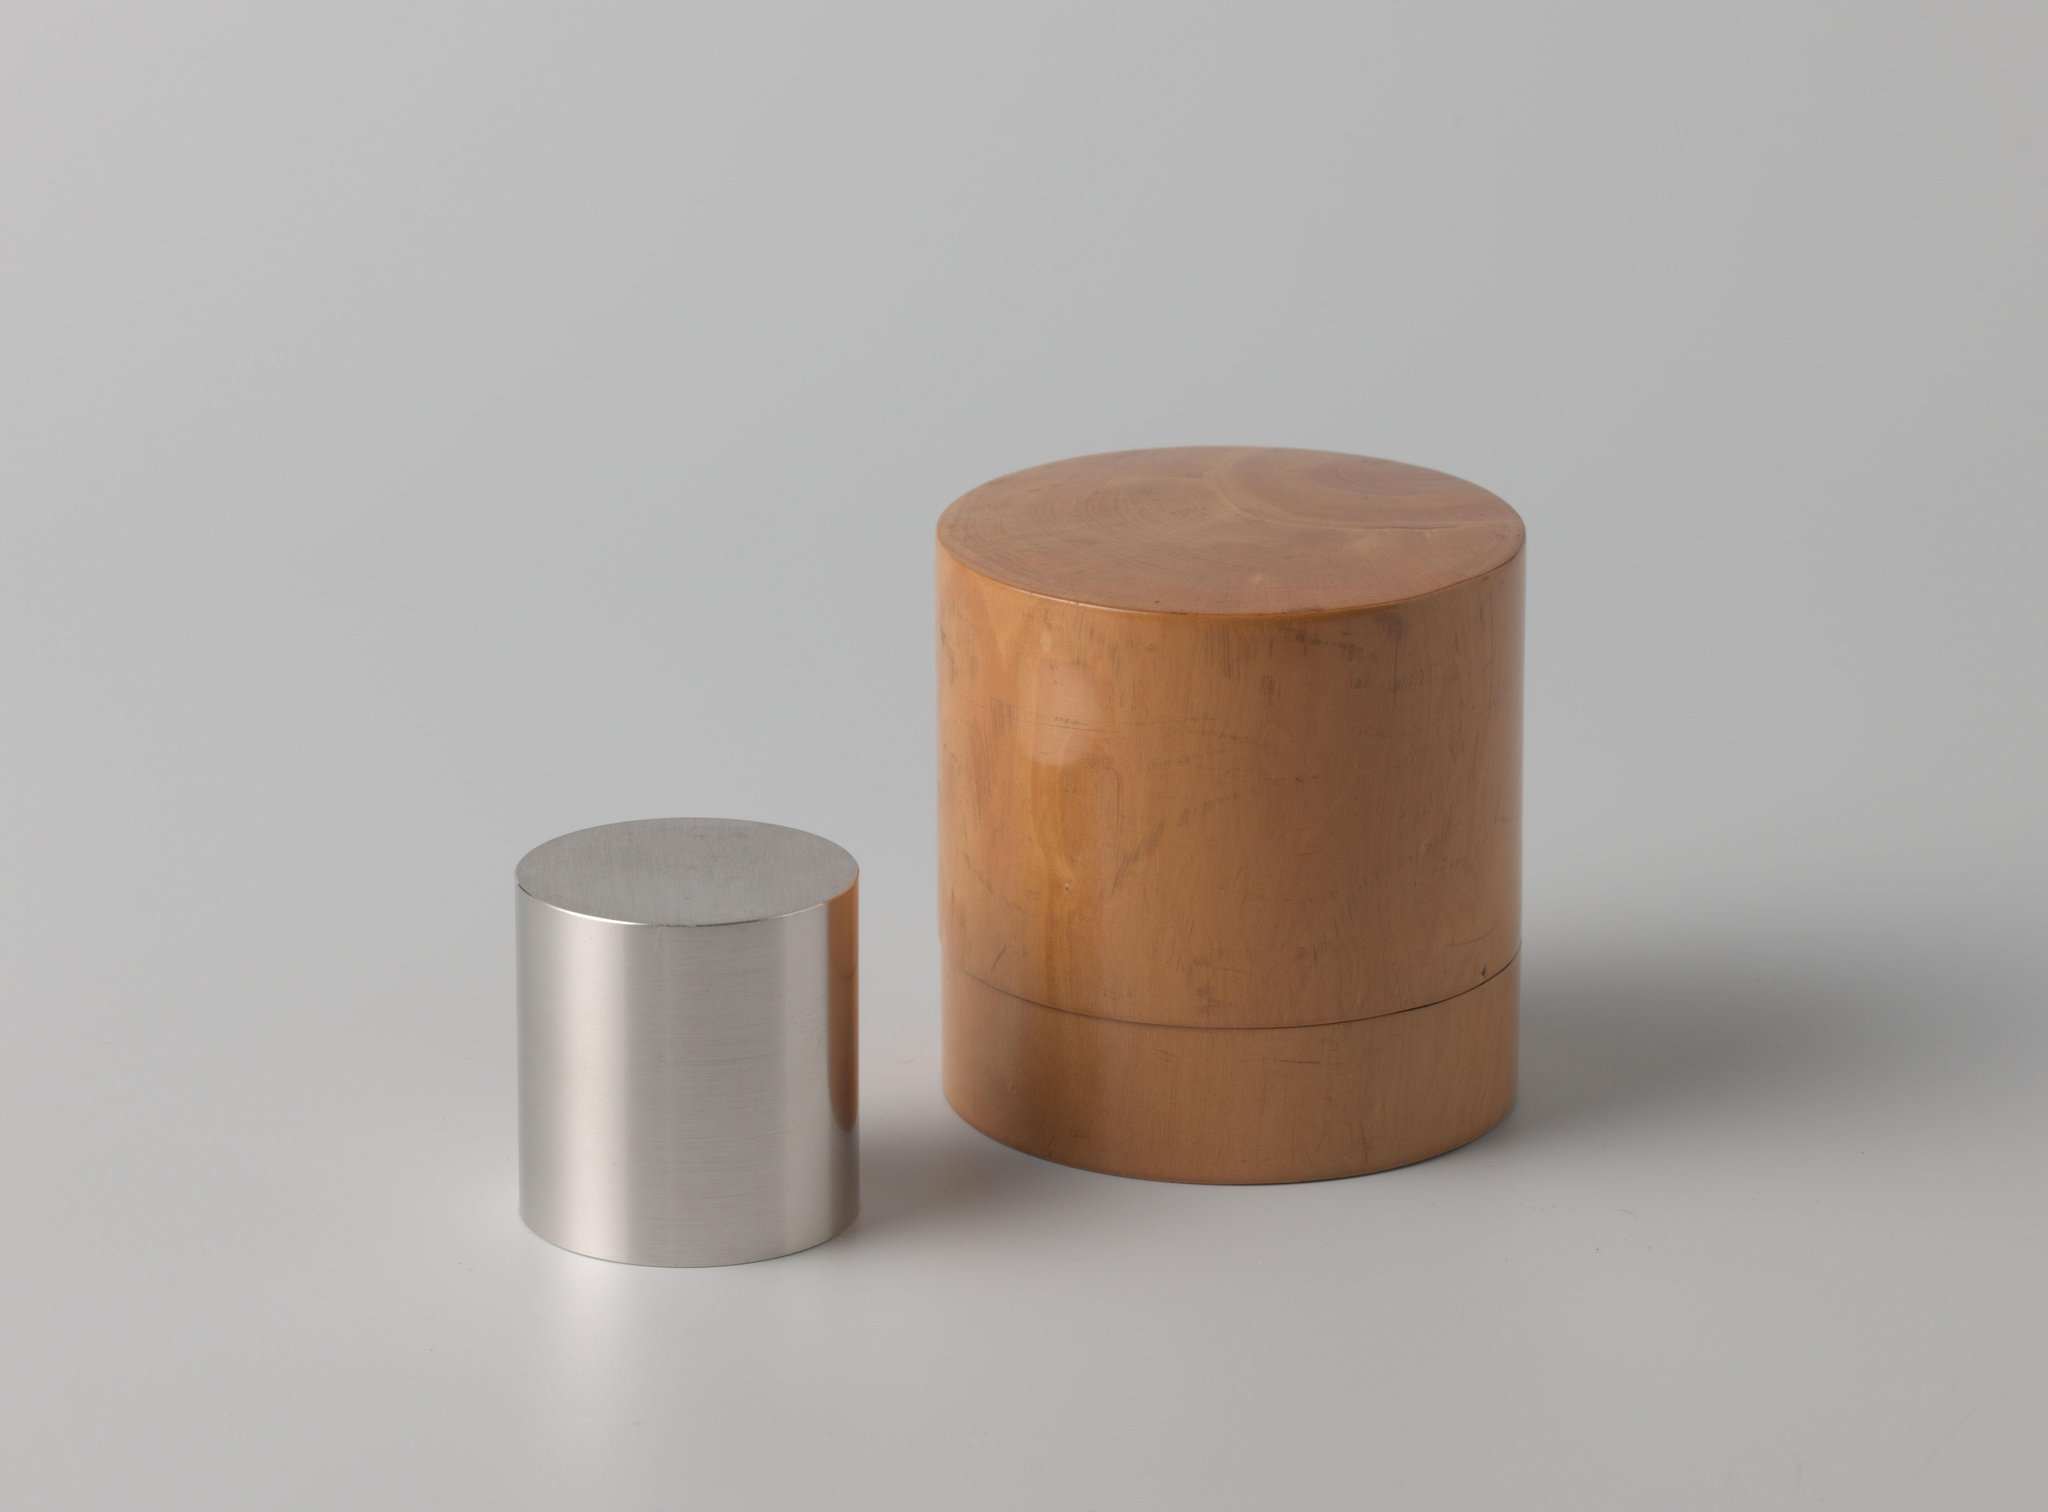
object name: cassette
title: Platina standaard van 1 kg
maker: Anonymous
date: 1839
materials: copper, glass, metal, platinum, velvet, wood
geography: netherlands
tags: antoine lipkens, amsterdam, netherlands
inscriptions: inscription: ‘Platina Kilogramme bij ZrMs / besluit van den 12 April 1839 No129 / verklaard tot eenige standaard van het Ned. Pond / Deze Kilogramme, welks volumen bij 17° C / bedraagt 46959 Cub: millimetres, is bij onmid- / delijke vergelijking bevonden in het luchtledige veertien honderste deelen van een milligramme / zwaarder te zijn dan de oorspronkelijke / platina prototype berustende in de / Staats archieven te Parijs.’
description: Platina standaard, te Parijs vergeleken met het Kilogramme des Archives door een commissie, benoemd bij K.B. van 10 augustus 1838 no. 58 en bestaande uit: Antoine Lipkens (1782-1847), Rehuel Lobatto (1797-1866) en Pieter Johannes Uijlenbroek (1798-1844). Bij K.B. van 12 april 1839 werd dit gewicht tot standaard verklaard van het Nederlands Pond en in bewaring gegeven bij het Koninlijk Instituut, de latere Koninklijke Akademie van Wetenschappen te Amsterdam. In 1887 werd de standaard naar de Polytechnische school, de latere Technische Hogeschool, te Delft overgebracht. Bij K.B. van 24 maart 1954 no. 171 is dit gewicht als standaard vervangen door het platina - iridium kilogram no. 53. (etiket NMi).